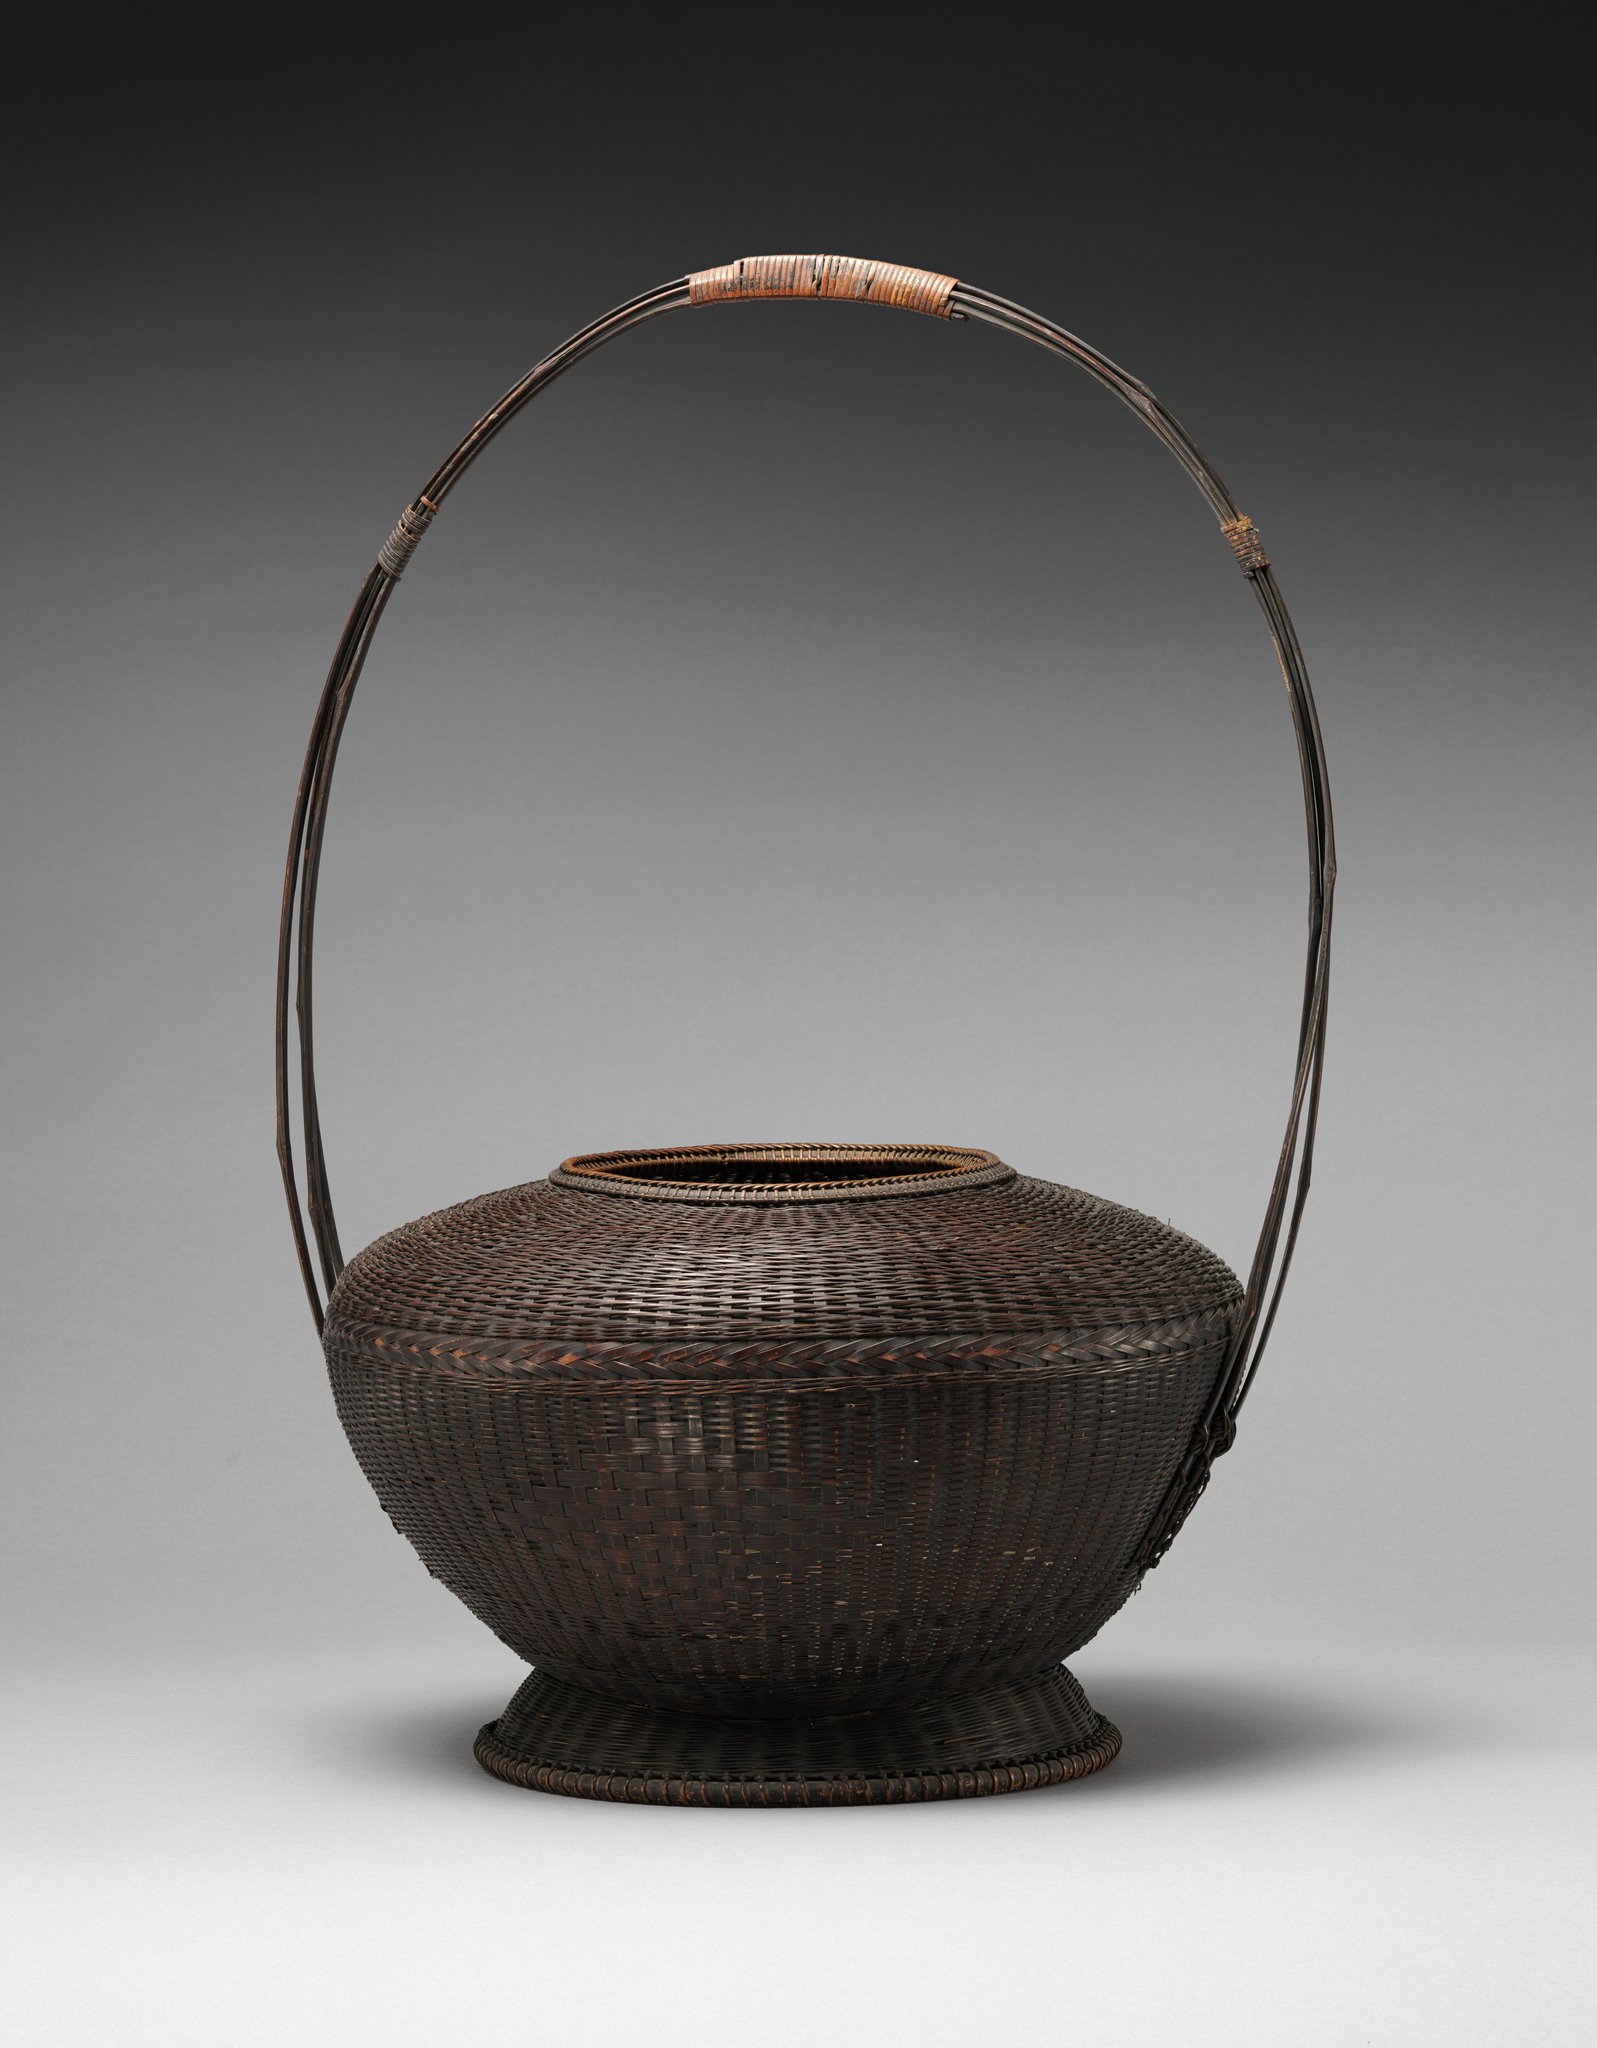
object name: basket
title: Basket for Peonies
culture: japanese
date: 1851-1900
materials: bamboo, rattan